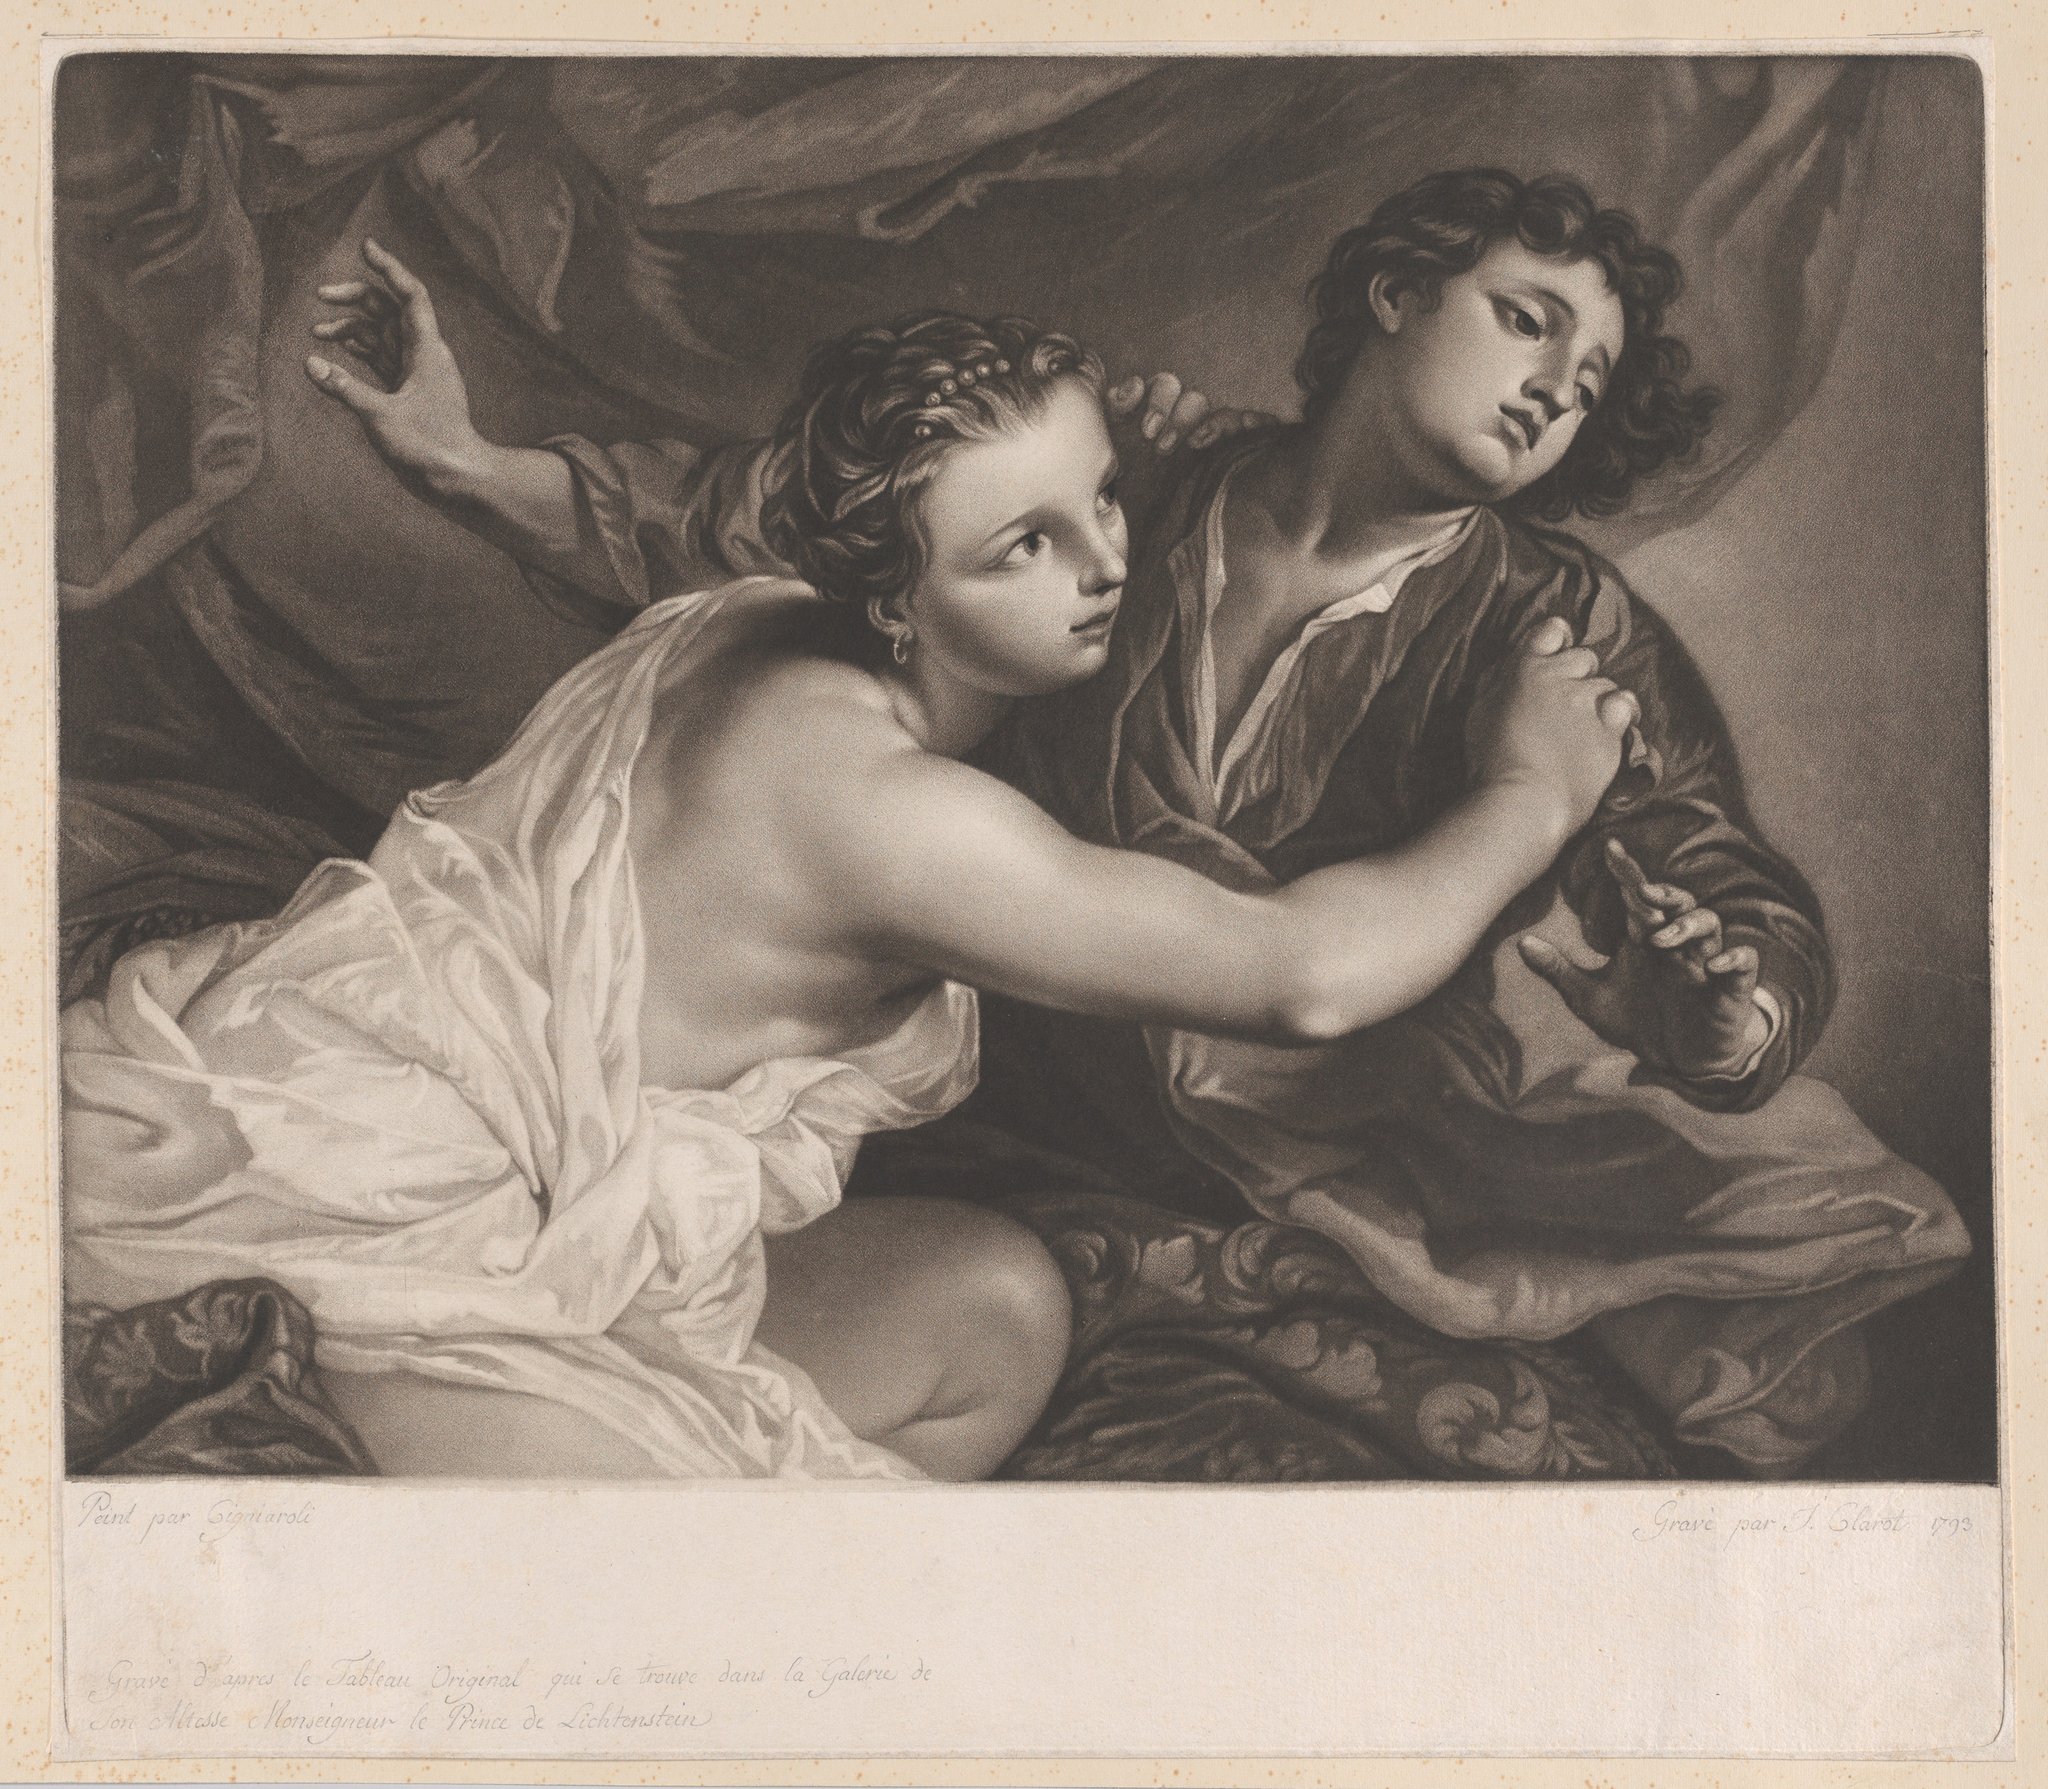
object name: print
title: Joseph and Potiphar's Wife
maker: joseph adrianus clarot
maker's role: artist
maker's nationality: austrian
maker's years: 1770-1820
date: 1793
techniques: mezzotint